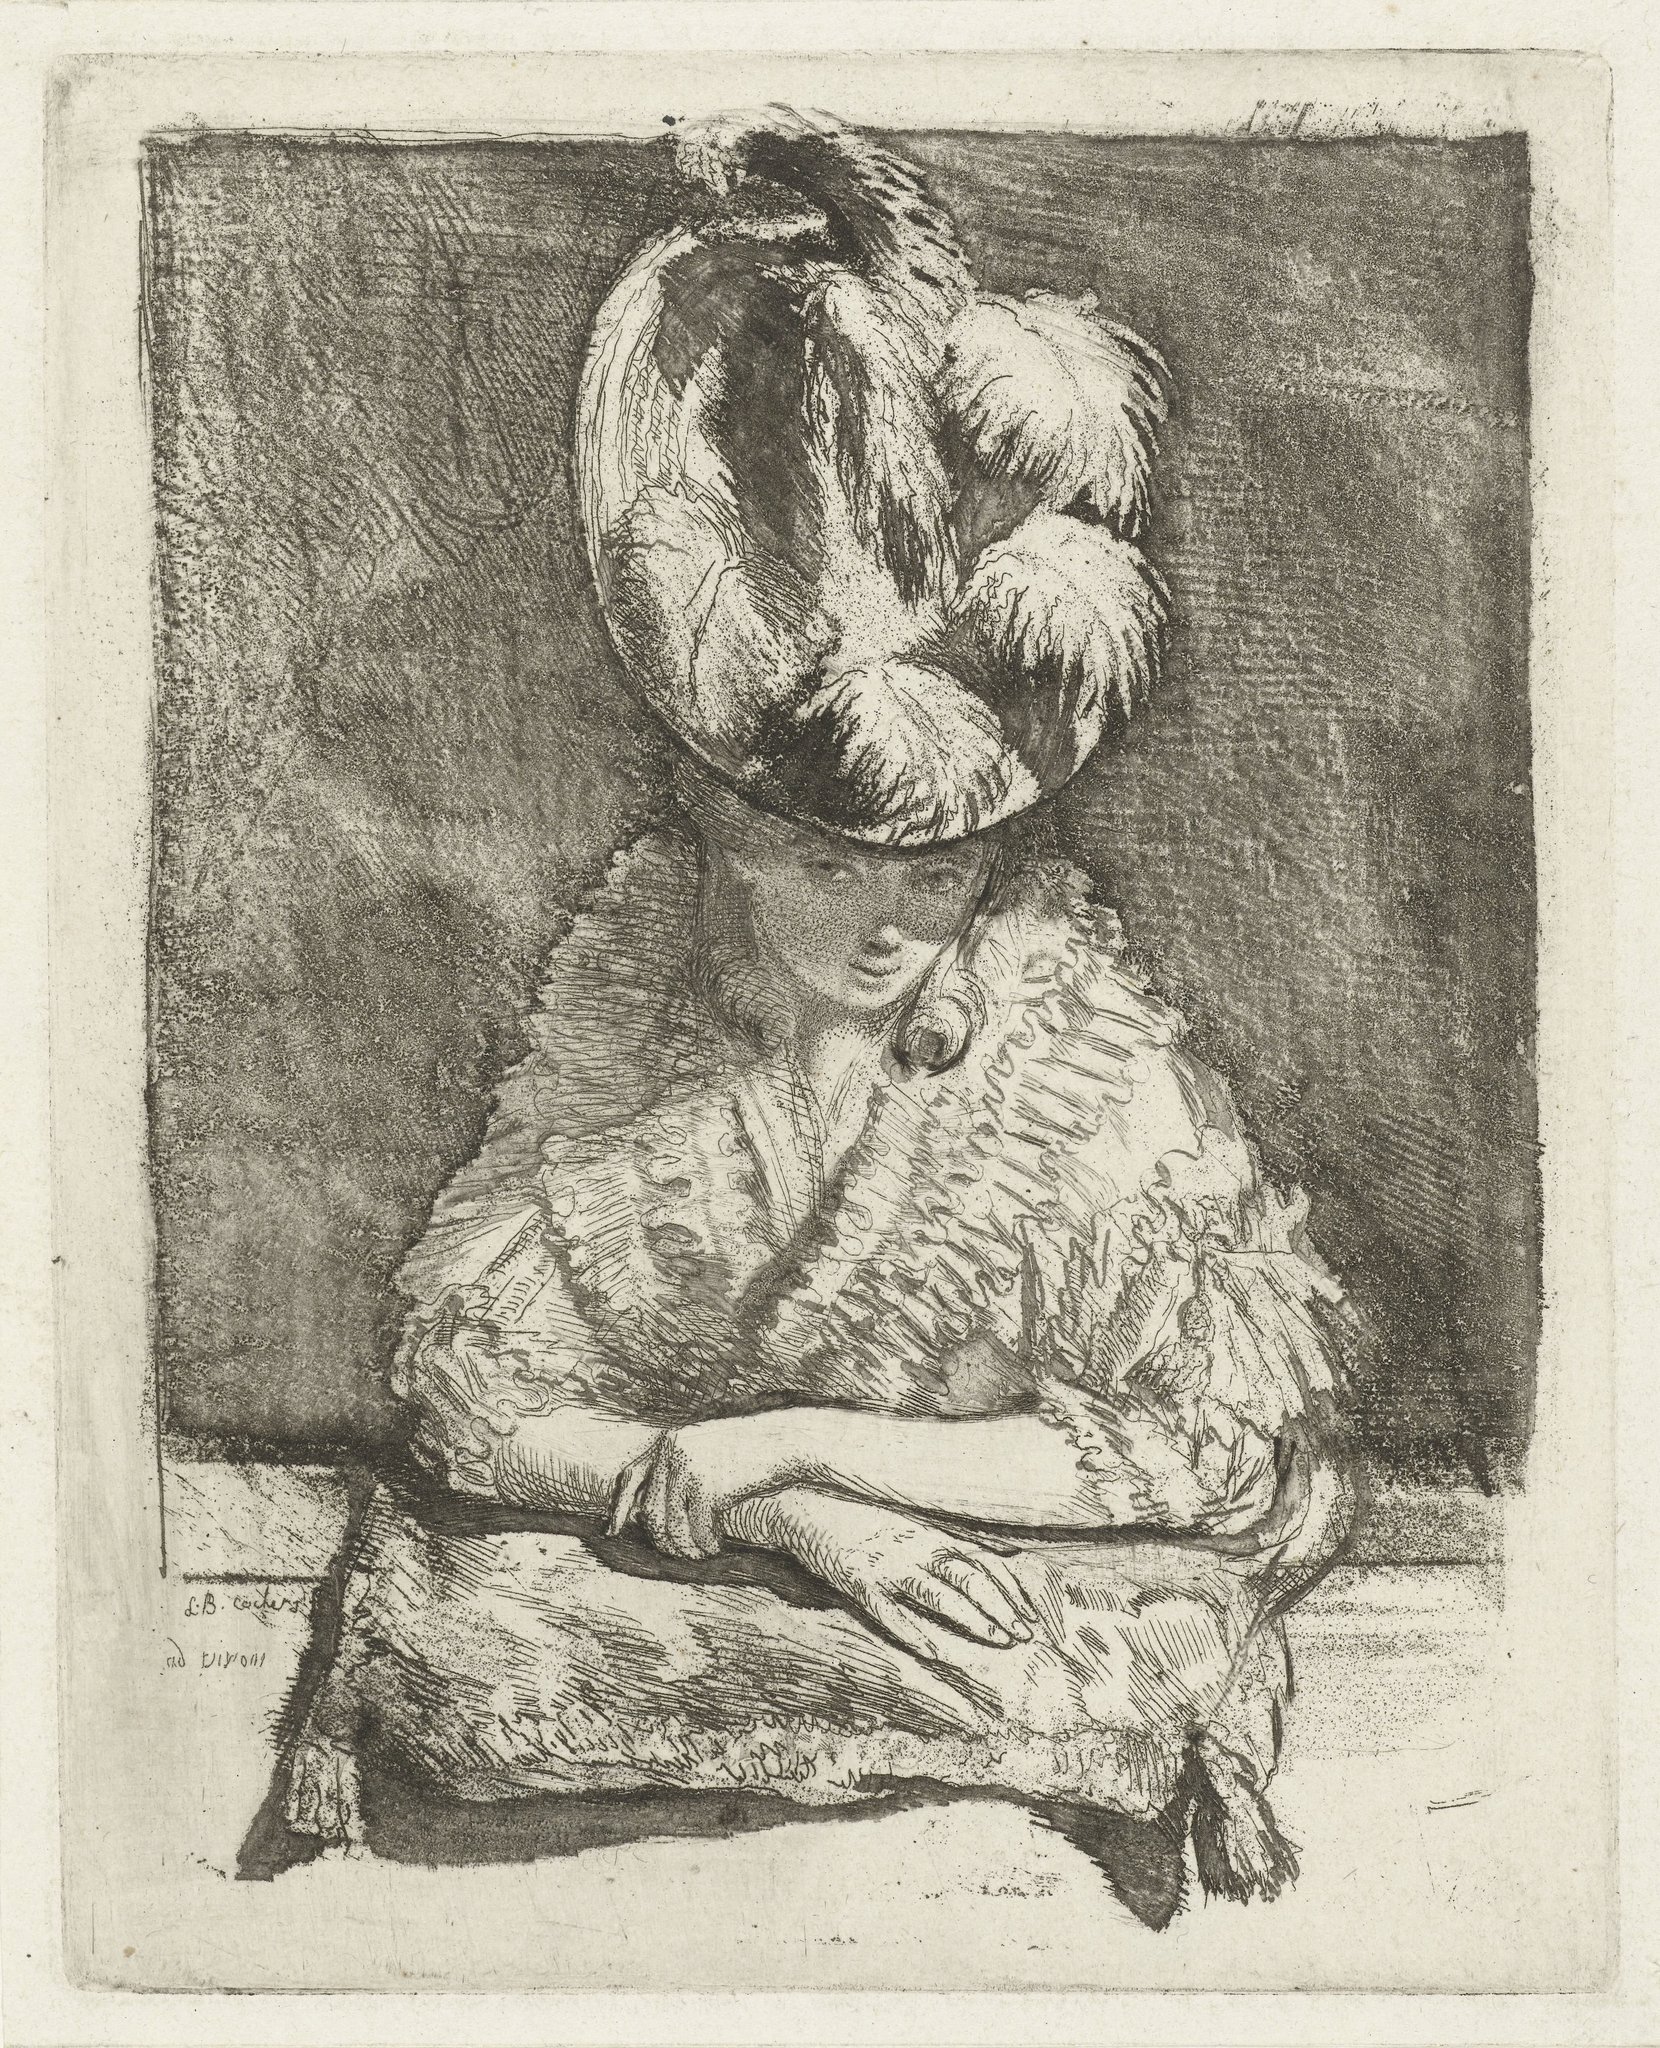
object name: print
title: Portret van een jonge vrouw met hoed die uit het raam kijkt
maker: louis bernard coclers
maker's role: draughtsman, print maker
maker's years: 1741-1817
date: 1756-1817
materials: paper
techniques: drypoint, etching, intaglio, roulette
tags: human figure at (open) window, seen from outside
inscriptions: collector's mark: Lugt 2228